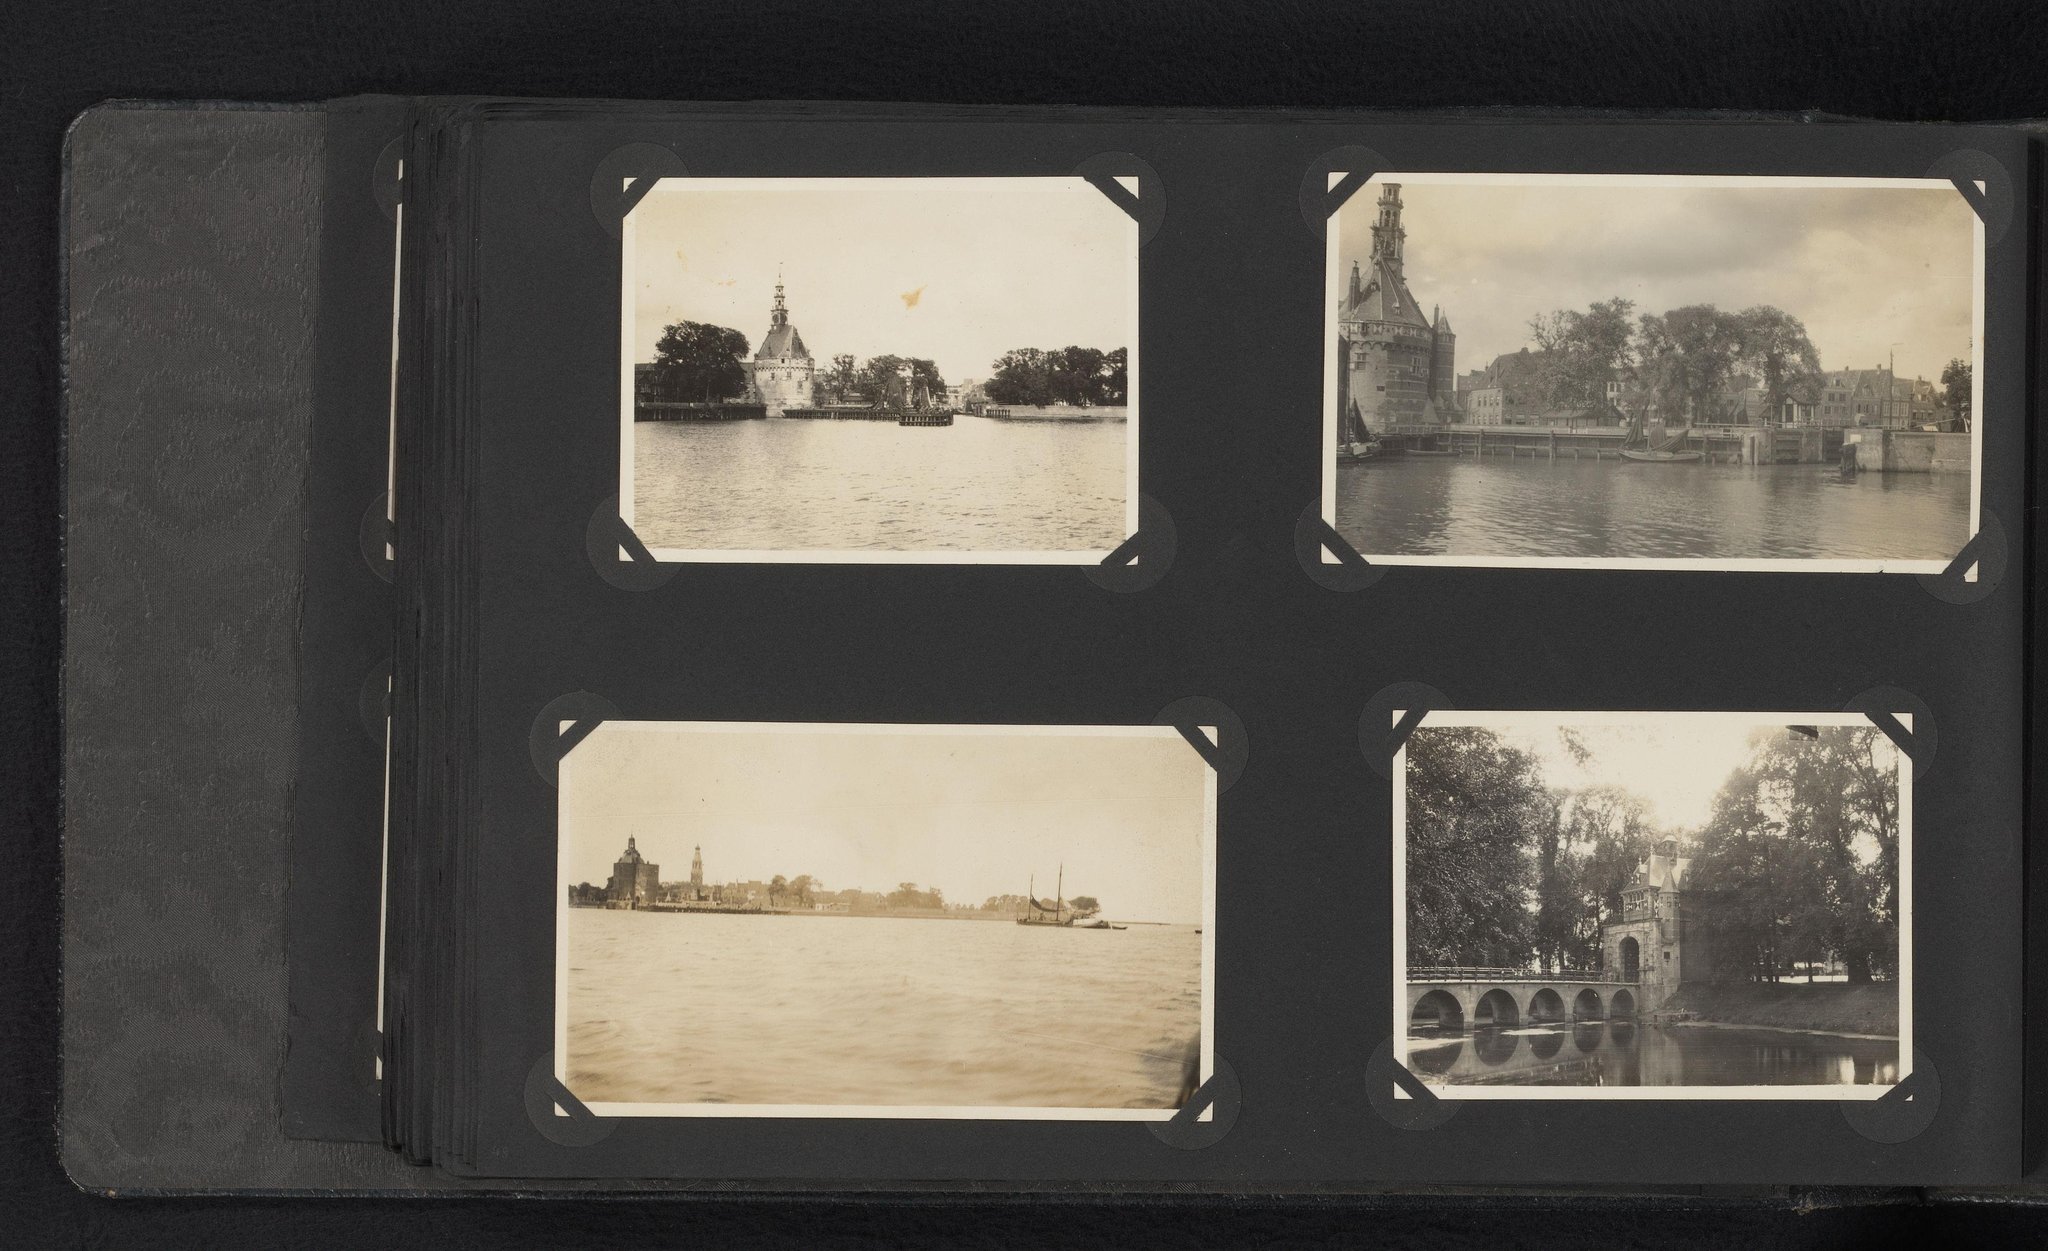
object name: photograph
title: Vier foto's van rivieren en monumenten in Nederland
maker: hendrik herman van den berg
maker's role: amateurfotograaf, jurist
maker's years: 1875-1944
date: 1926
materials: paper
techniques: gelatin silver print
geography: netherlands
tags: river, gate, entrance, netherlands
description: Deze foto's maken deel uit van een album.